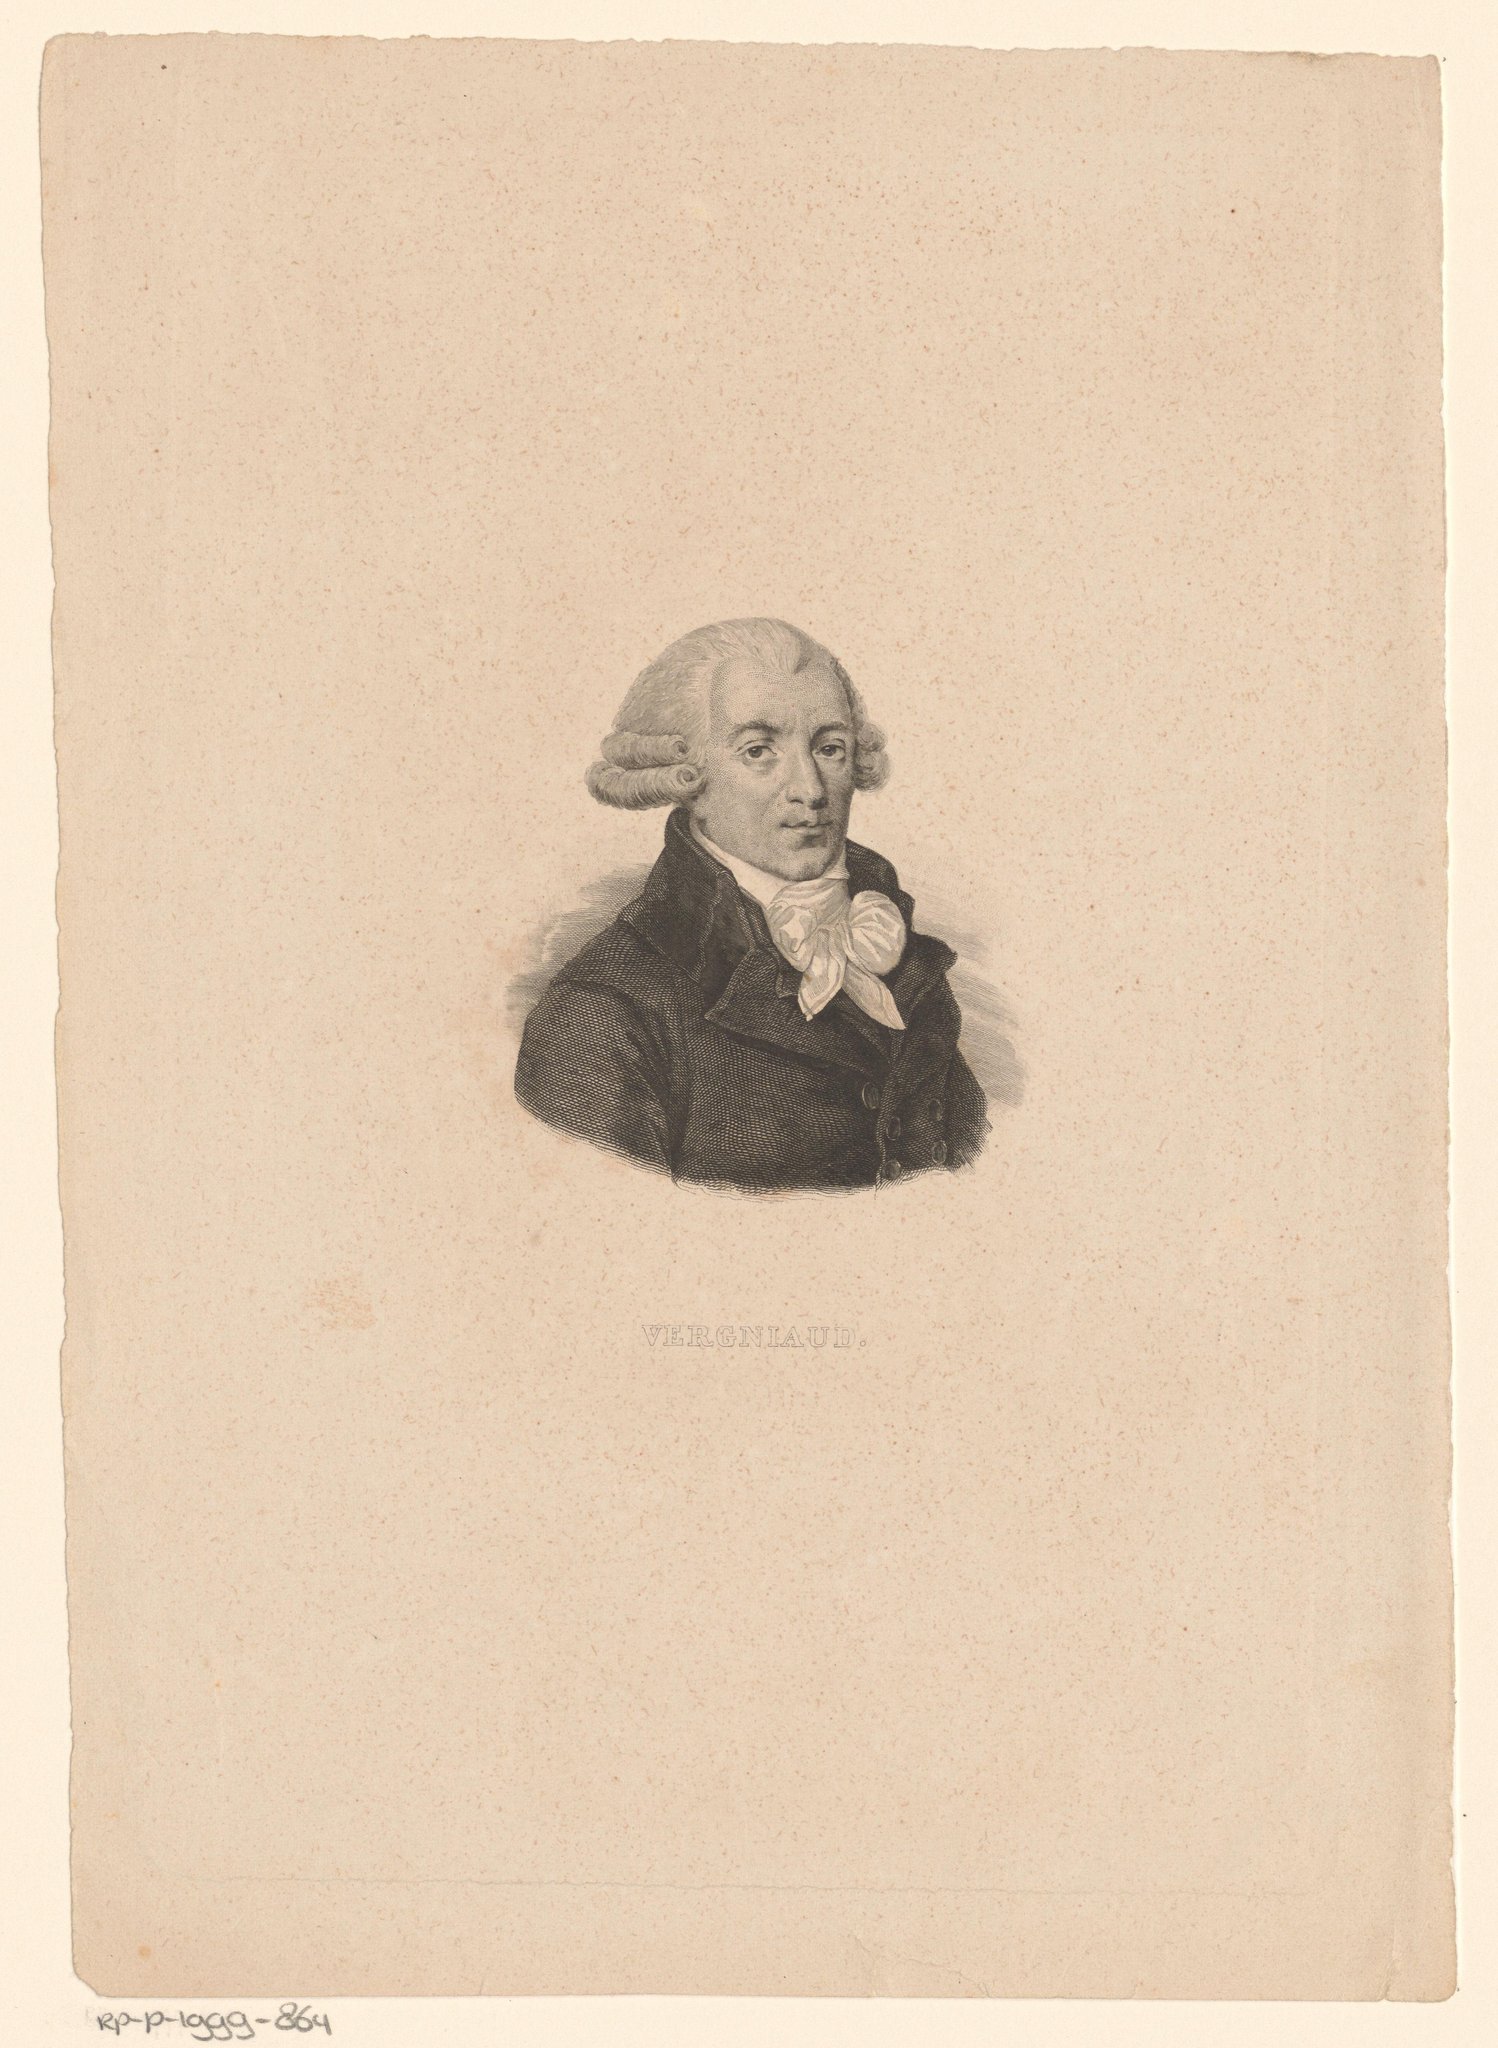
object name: print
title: Portret van Pierre Victurien Vergniaud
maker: Anonymous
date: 1800-1899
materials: paper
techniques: engraving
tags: politician, historical persons, politician, e.g. party leader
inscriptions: collector's mark: Lugt 2760, collector's mark: Lugt 2228